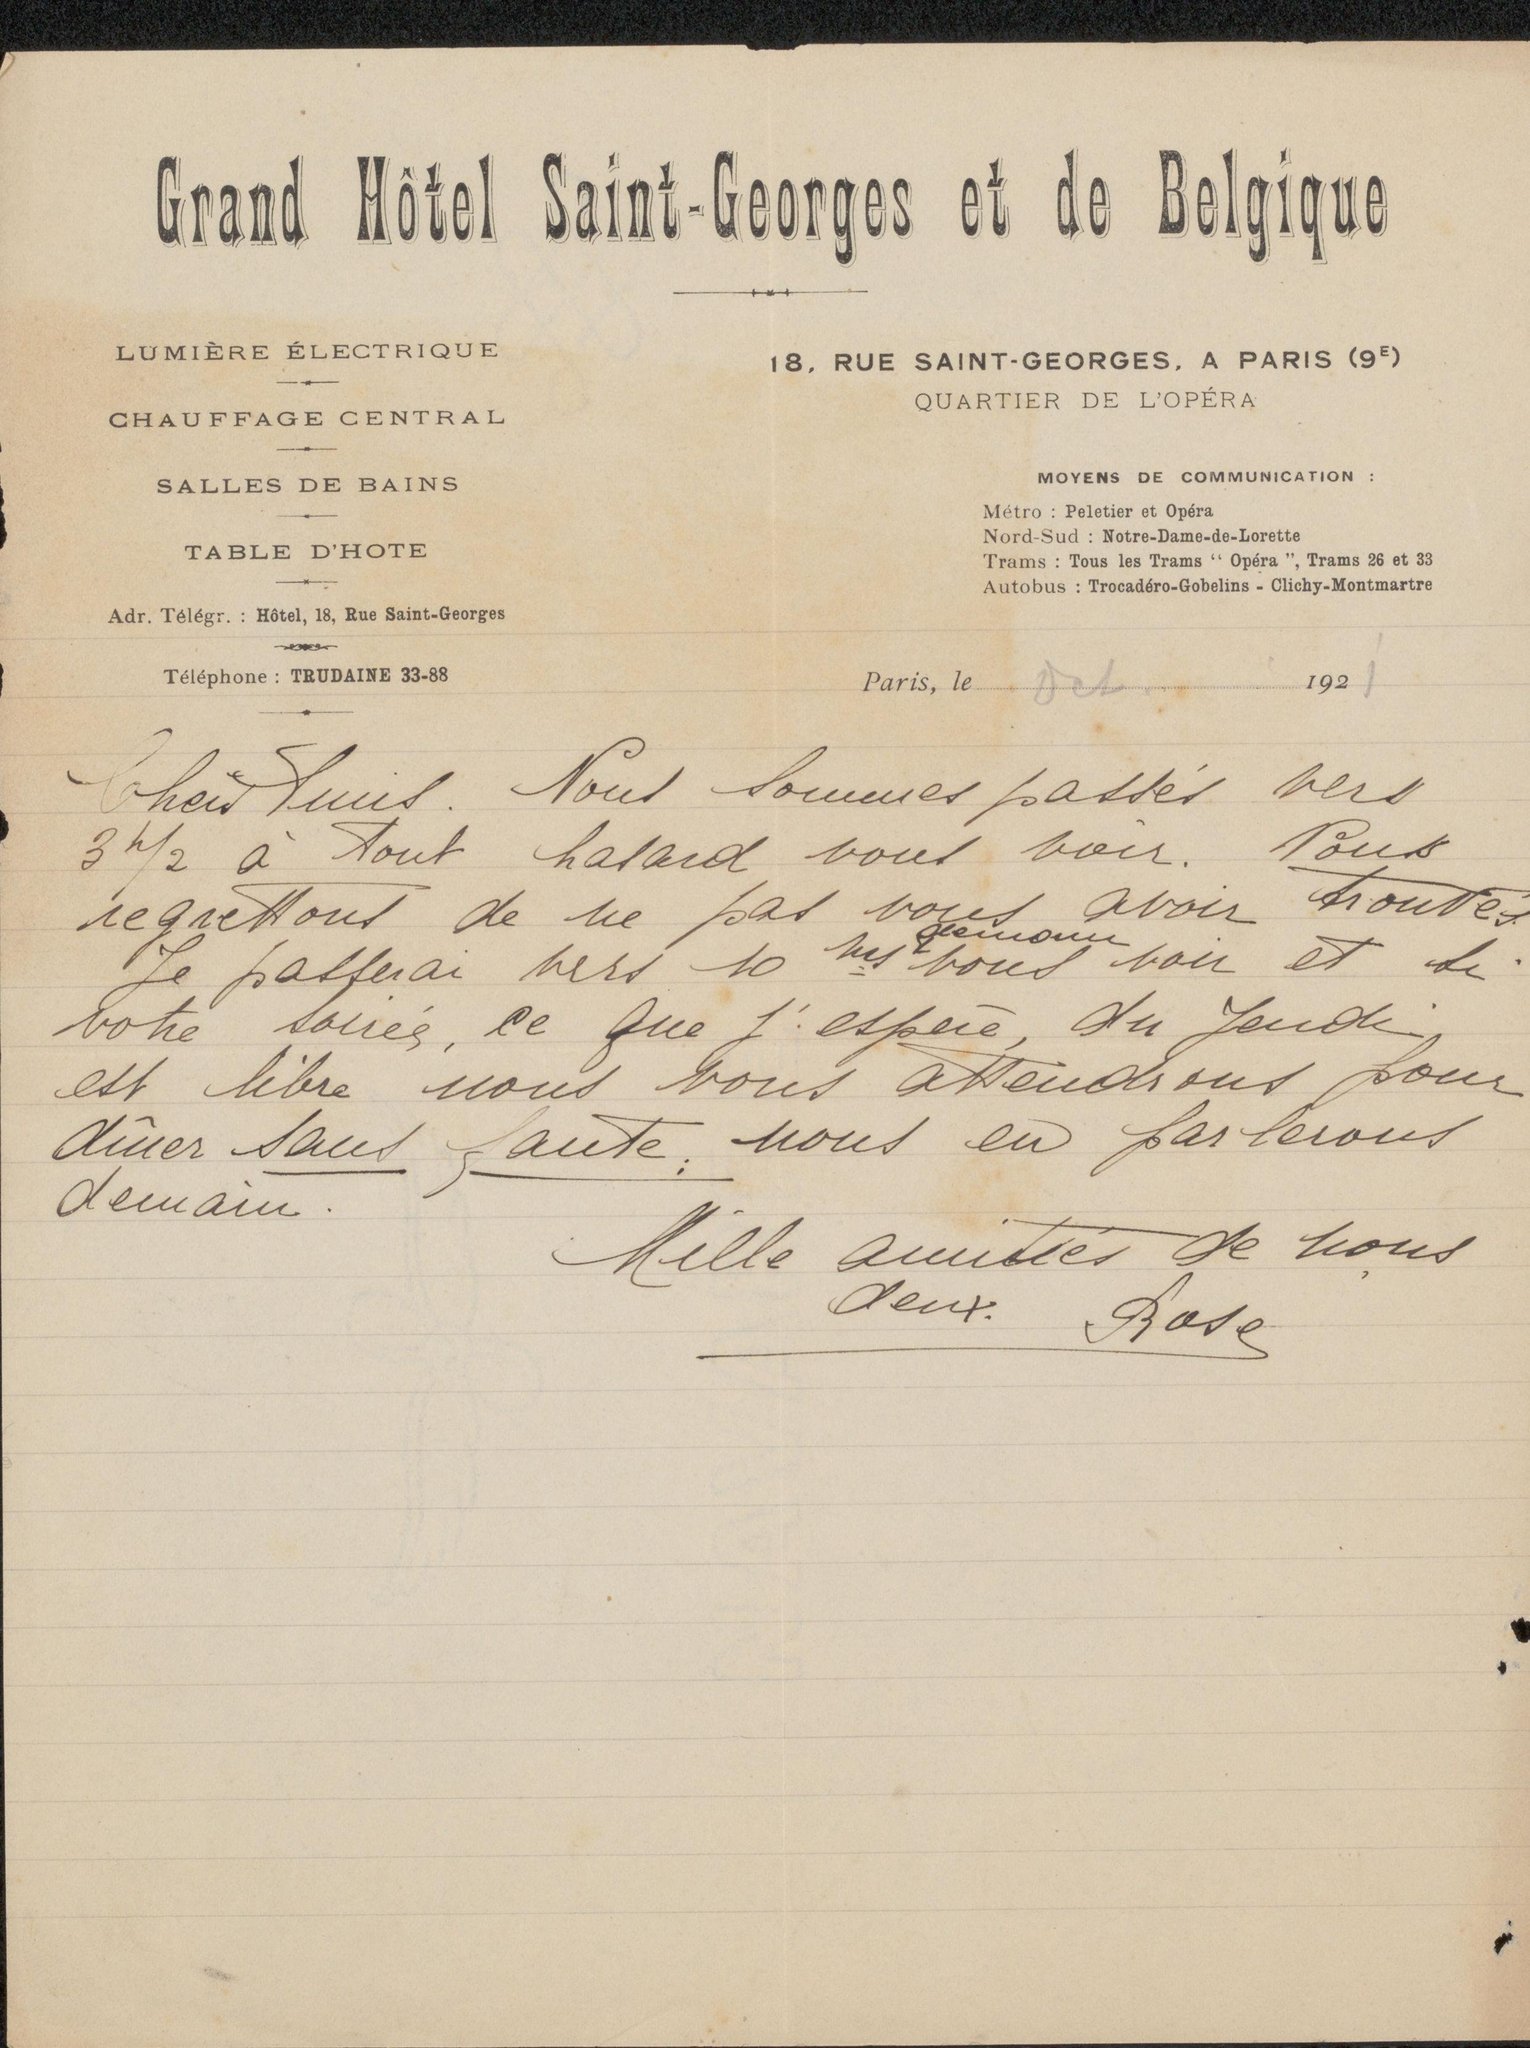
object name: letter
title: Brief aan Philip Zilcken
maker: rose imel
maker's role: draughtsman, painter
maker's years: 1901-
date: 1910-1921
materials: ink, pencil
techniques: pen, printing, writing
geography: paris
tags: painter, draughtsman, philip zilcken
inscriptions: collector's mark: ‘RPK’